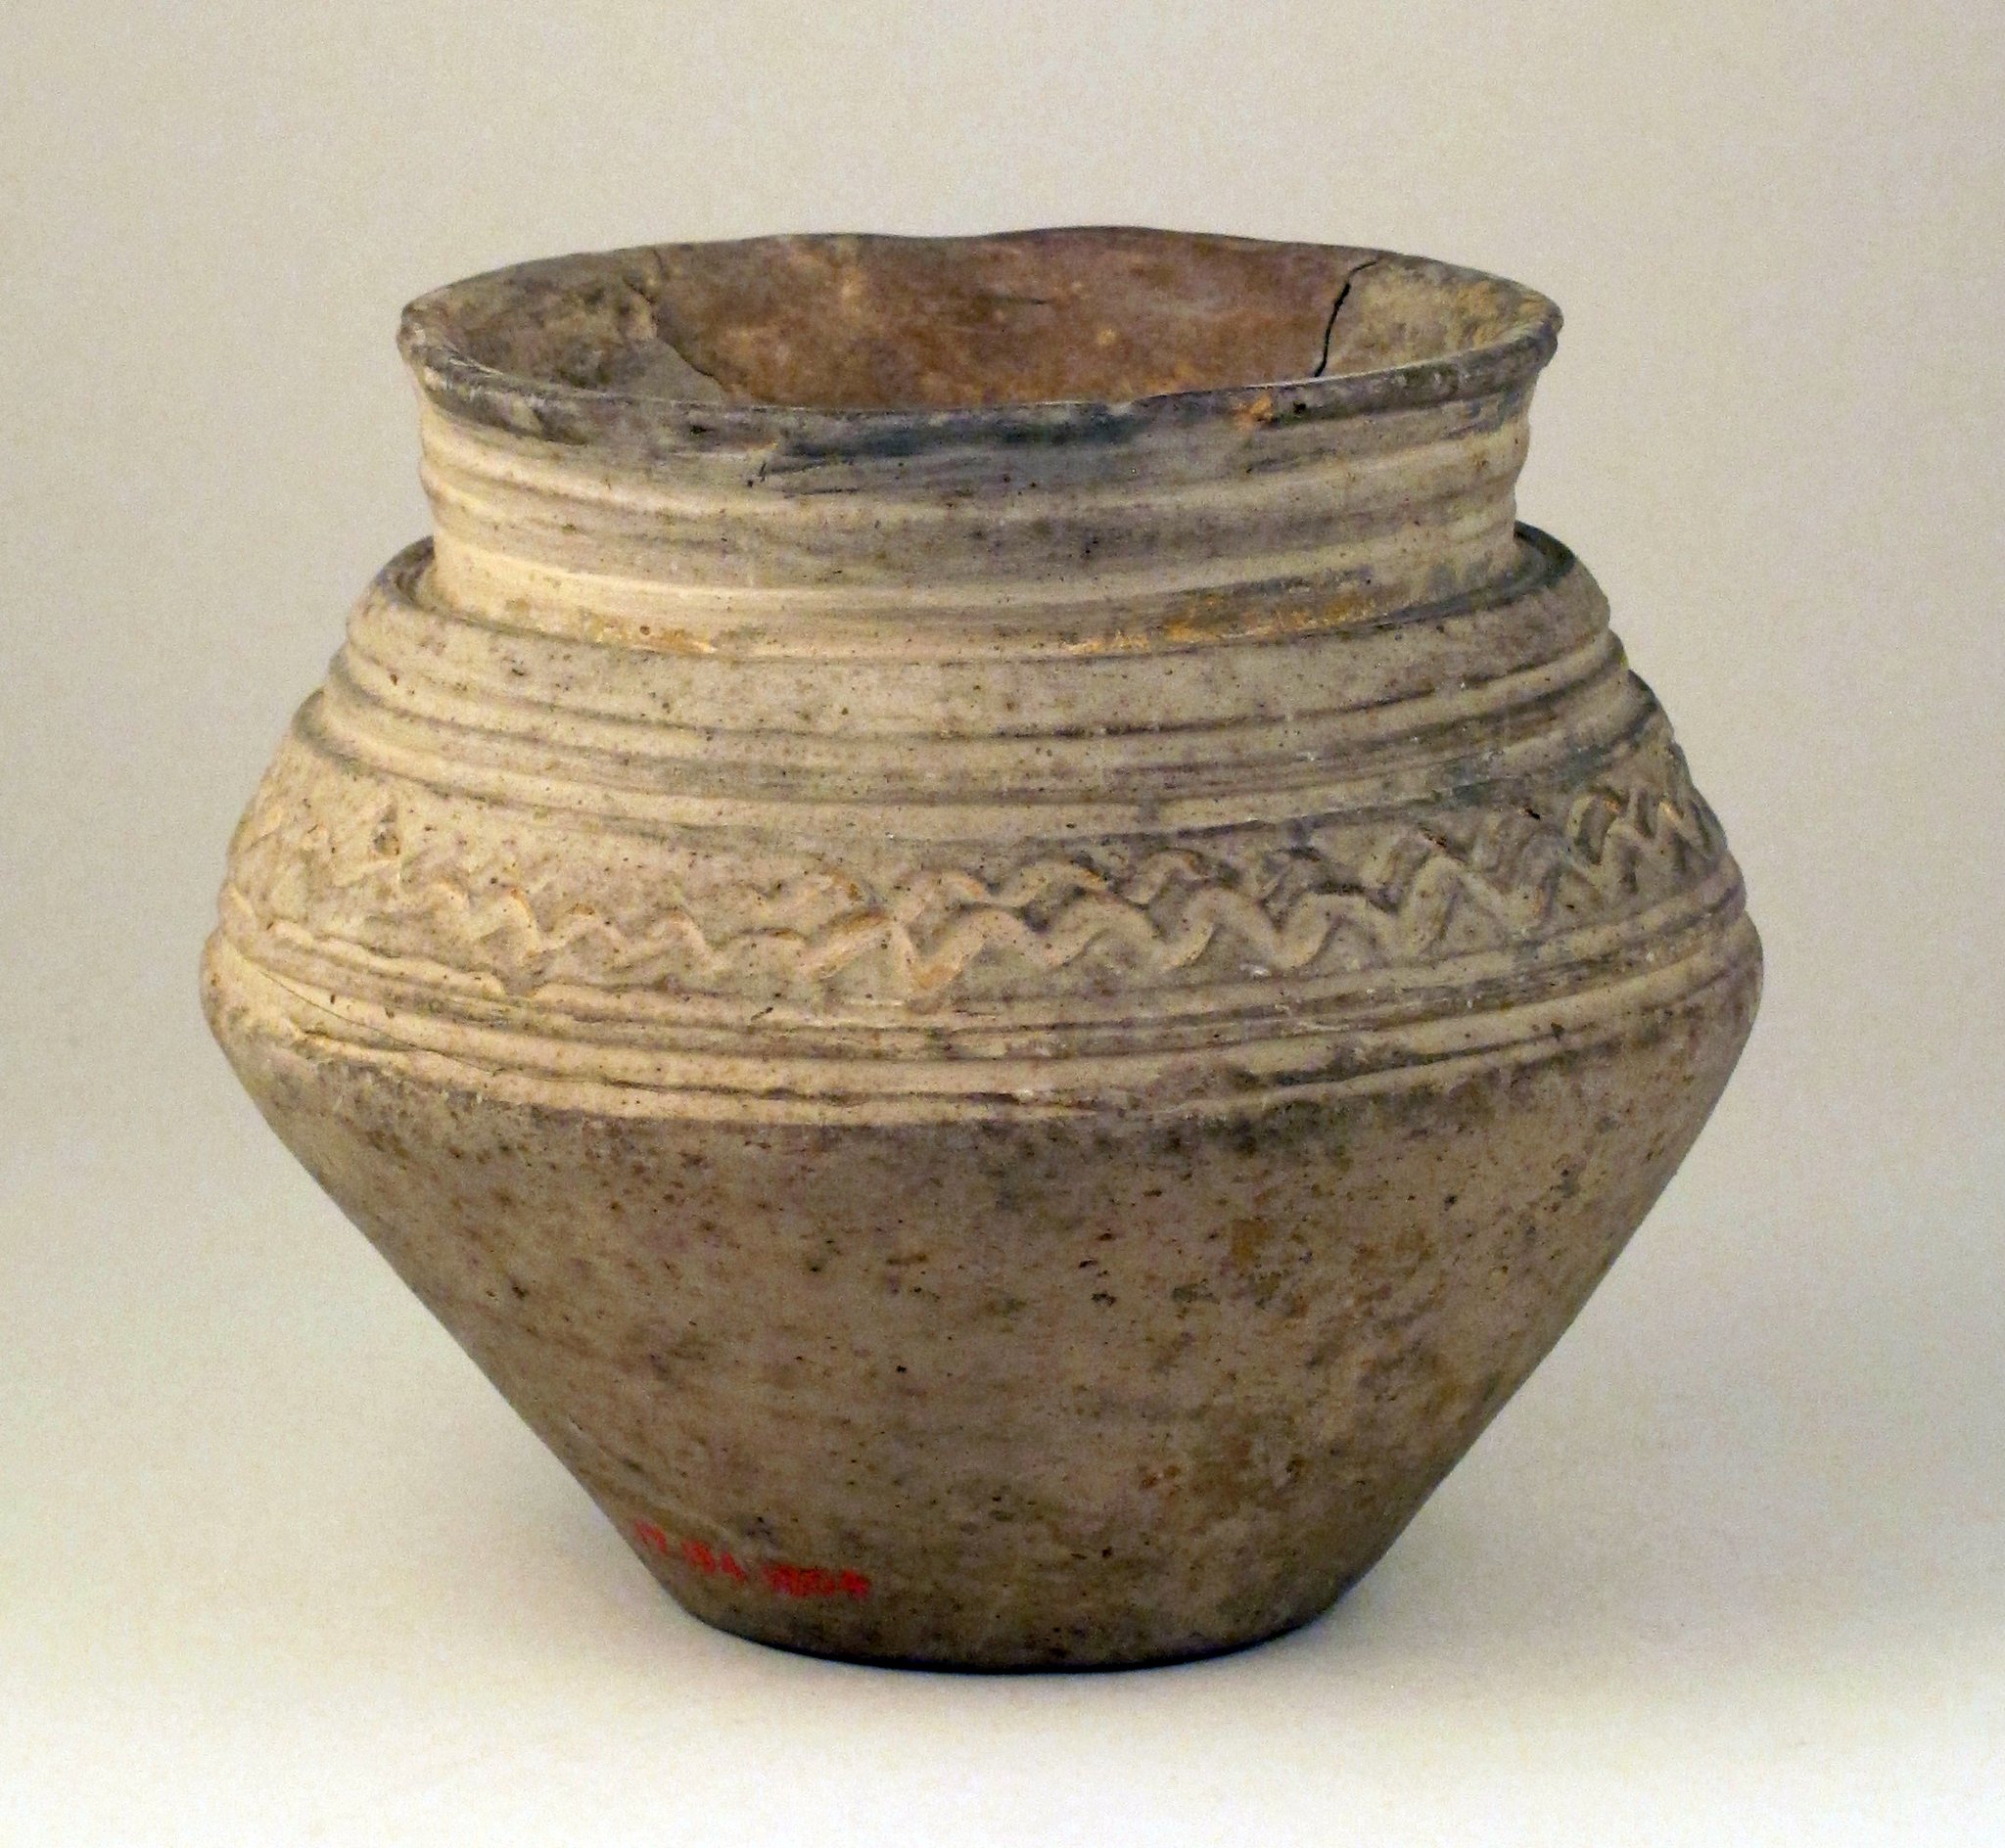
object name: vase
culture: roman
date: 670 BCE-330 CE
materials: terracotta